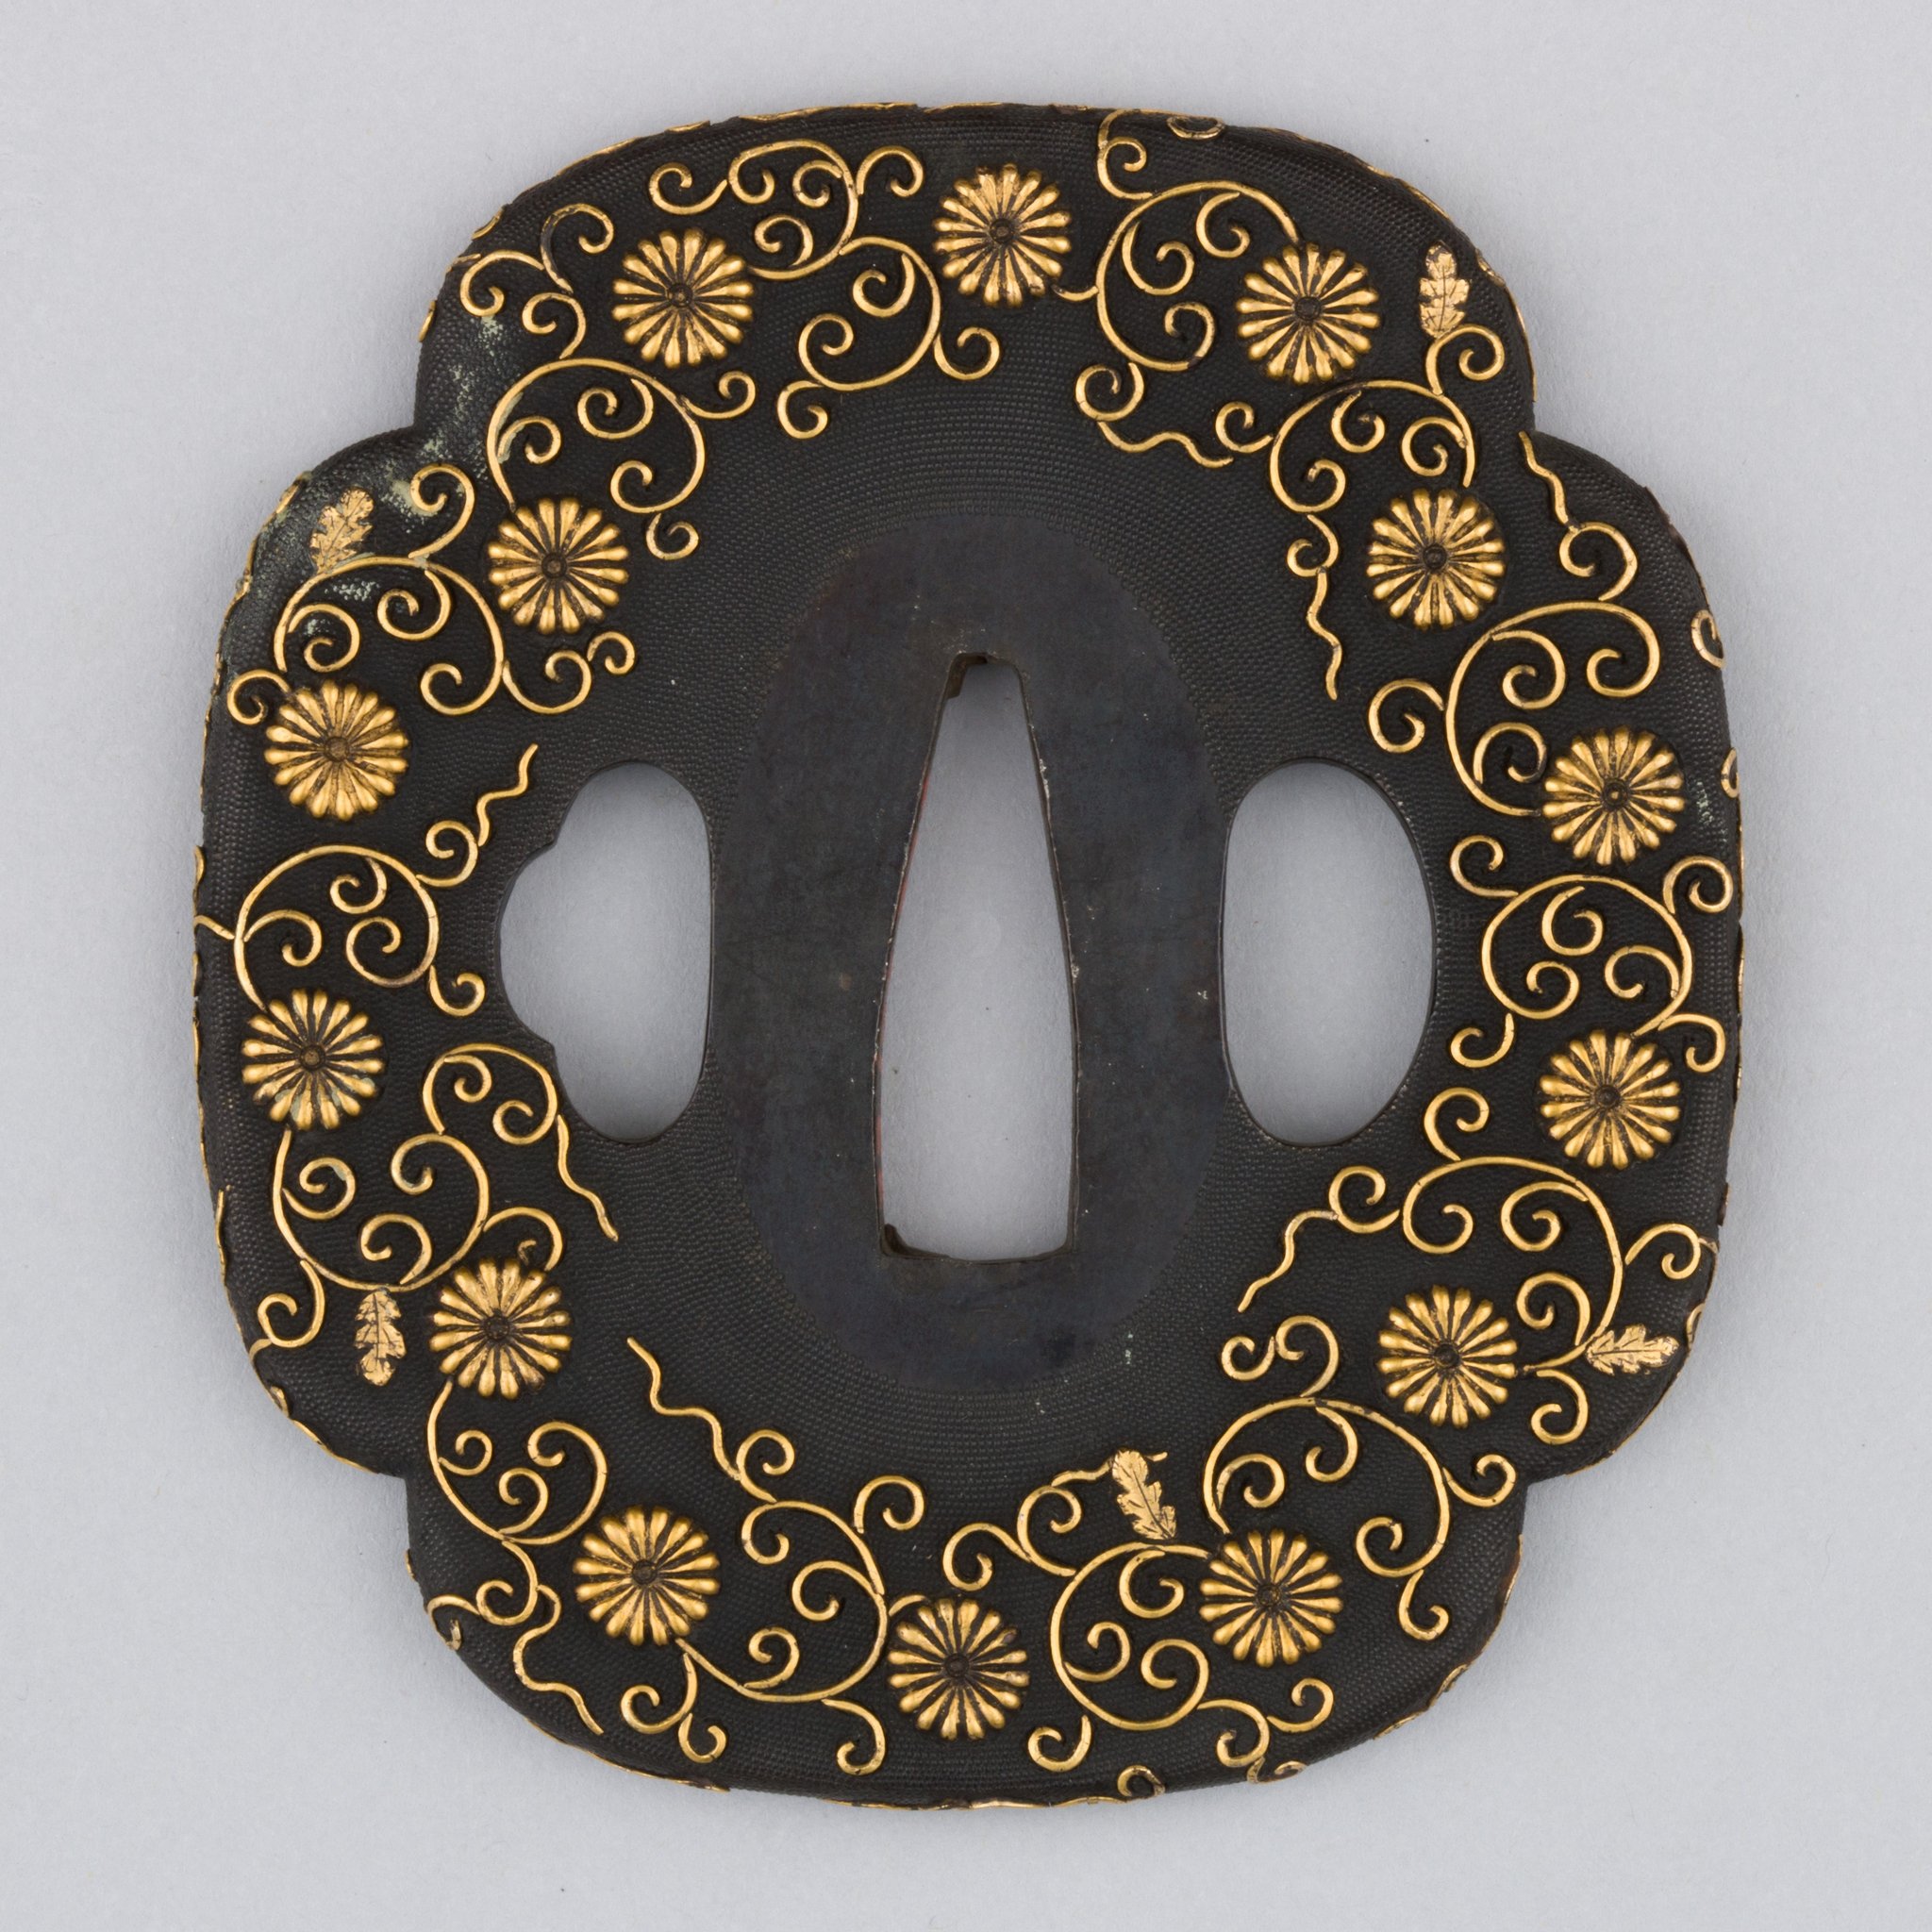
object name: sword guard tsuba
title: Sword Guard (Tsuba)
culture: japanese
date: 1615-1868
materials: copper, gold alloy, gold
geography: japan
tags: flowers